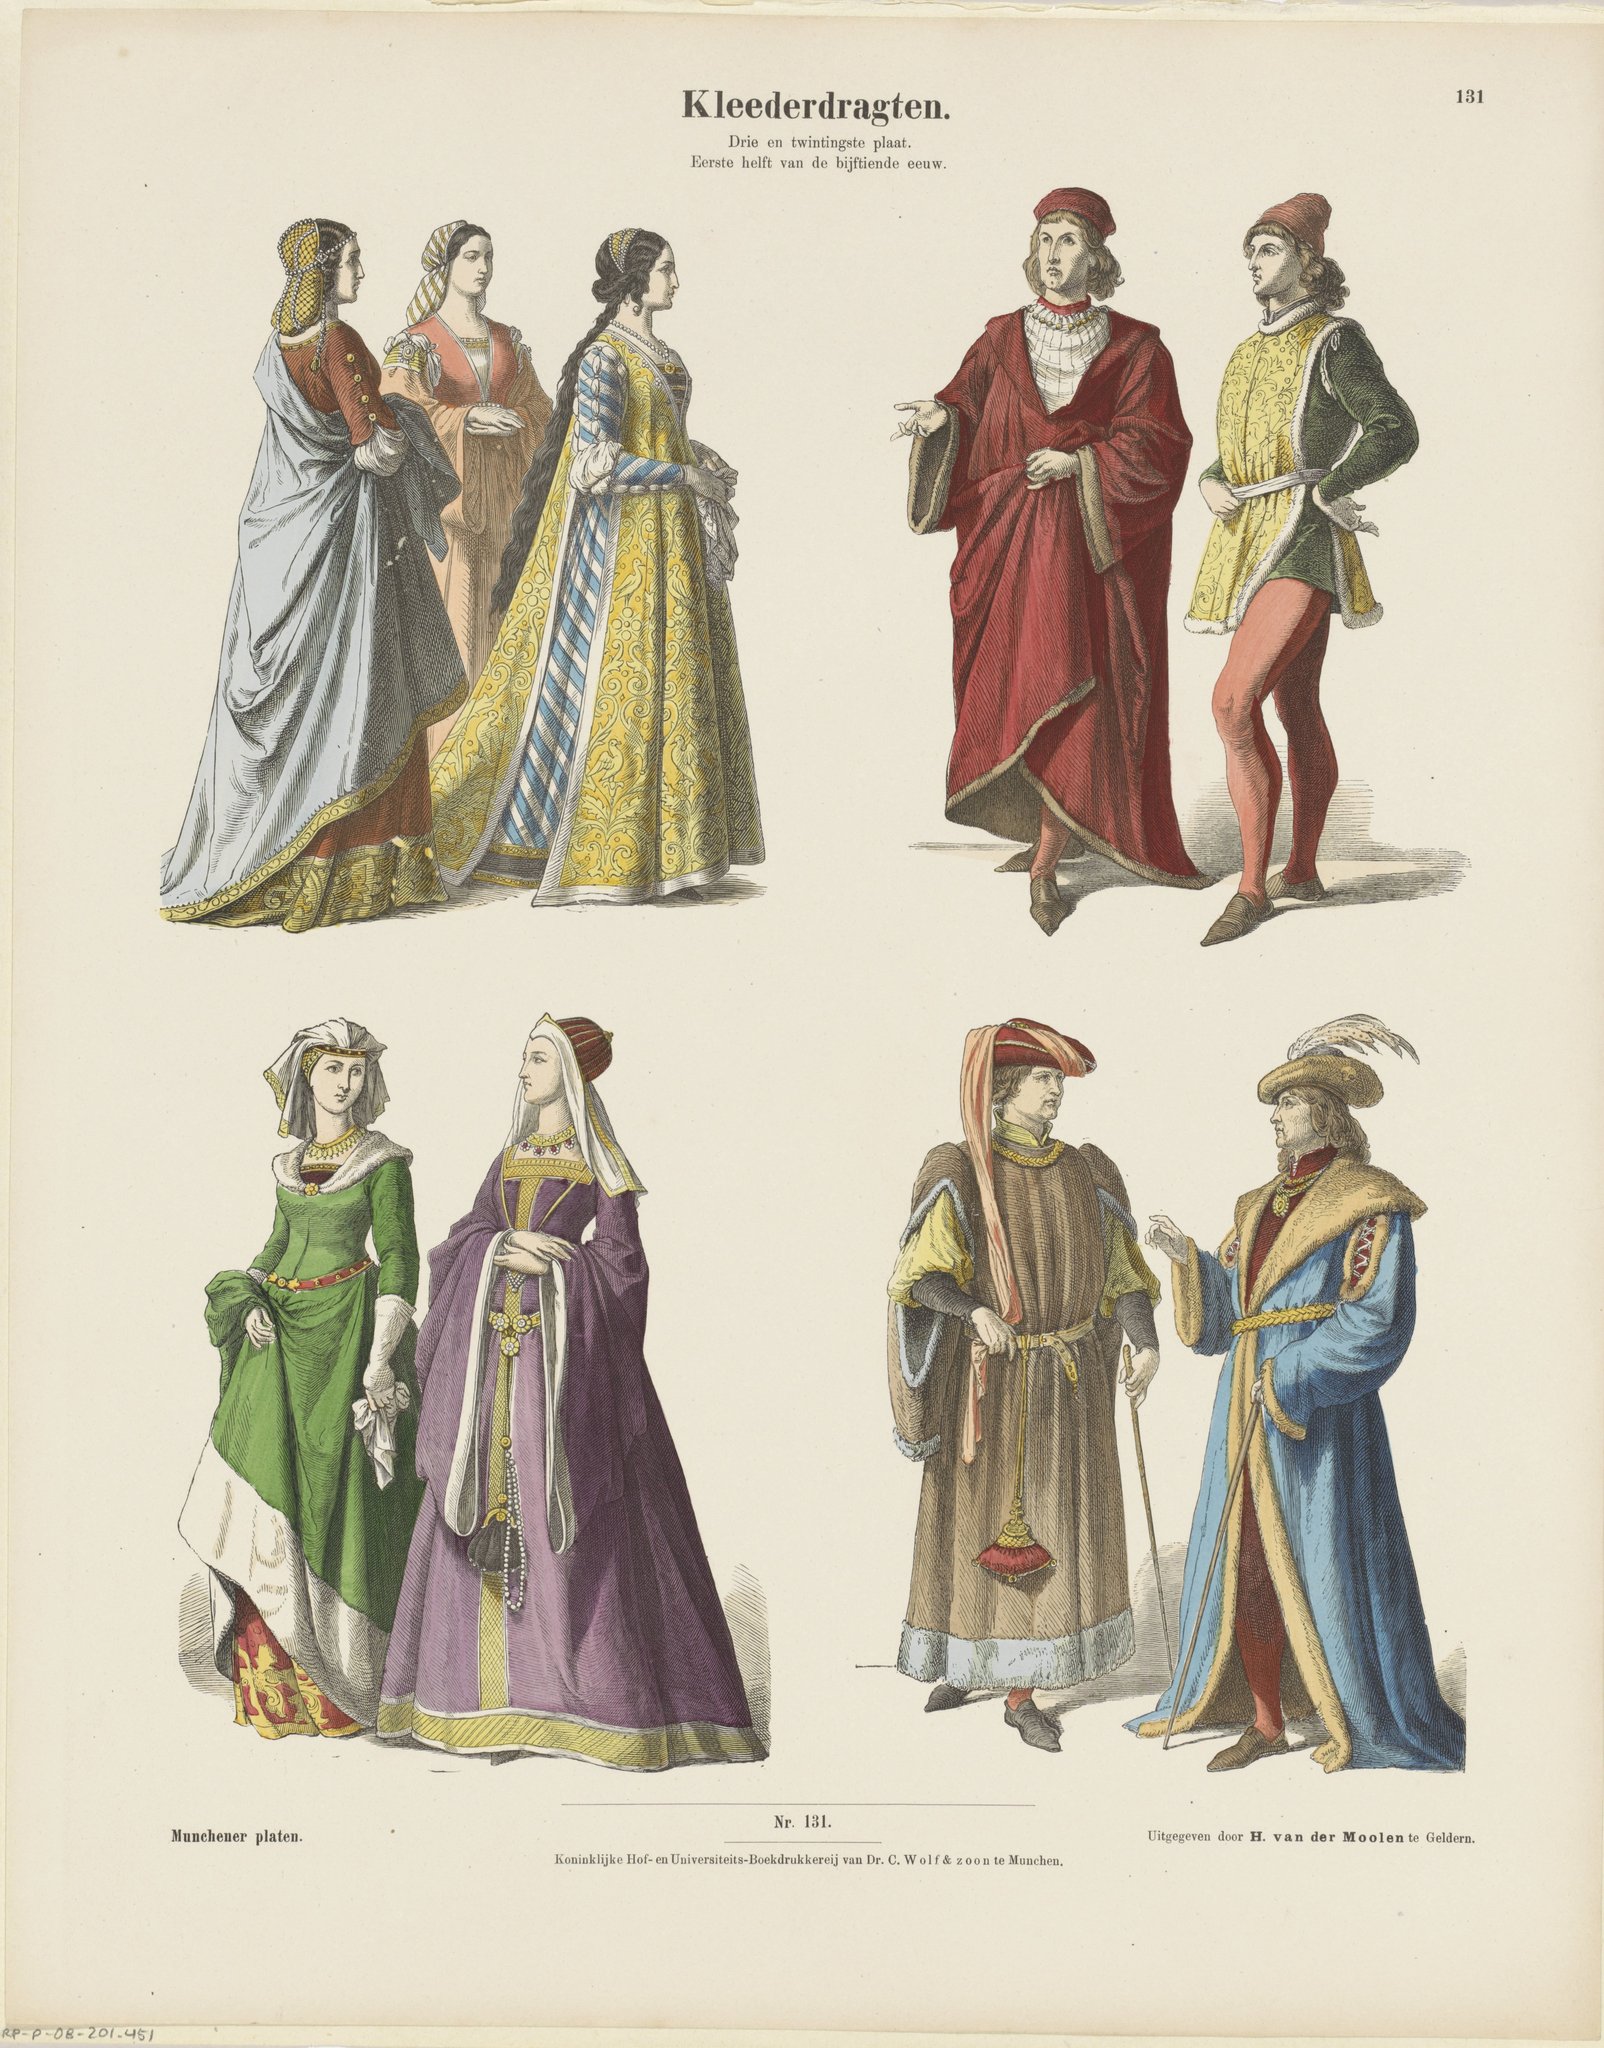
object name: print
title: Munchener platen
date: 1843-1920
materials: paper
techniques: colour, letterpress printing, engraving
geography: munich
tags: historical costume, folk costume, regional costume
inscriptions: collector's mark: Lugt 2760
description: Nederlandse editie van een prent uit de reeks "Munchener platen" uitgegeven door K. Braun & Fr. Schneider te München met het adres van wederverkoper Hermann van der Moolen.